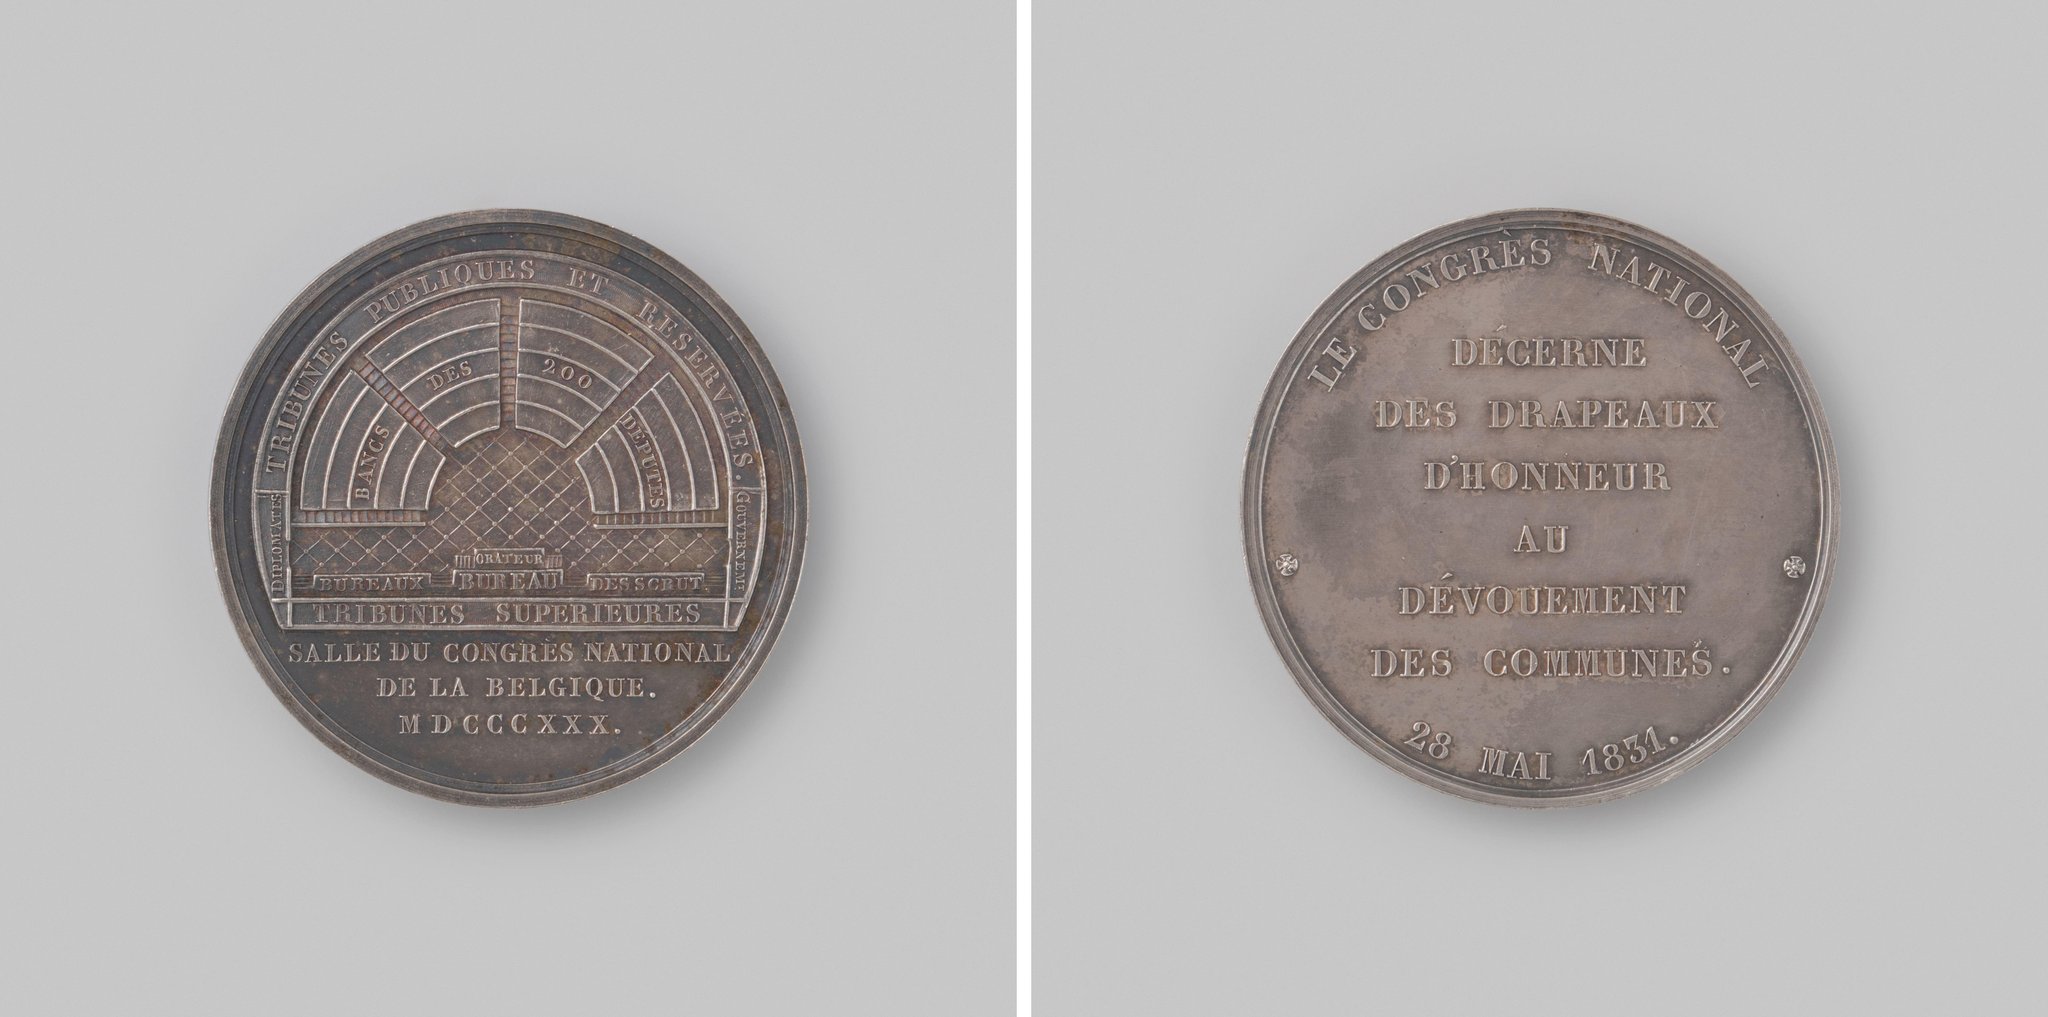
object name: history medal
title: Toekenning van erevaandels aan de Belgische gemeenten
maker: m. borrel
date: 1831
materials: silver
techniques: striking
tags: brussels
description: Zilveren penning. Voorzijde: zaal van Nationaal Congres van bovenaf gezien; afsnede: opschrift. Keerzijde: opschrift binnen omschrift